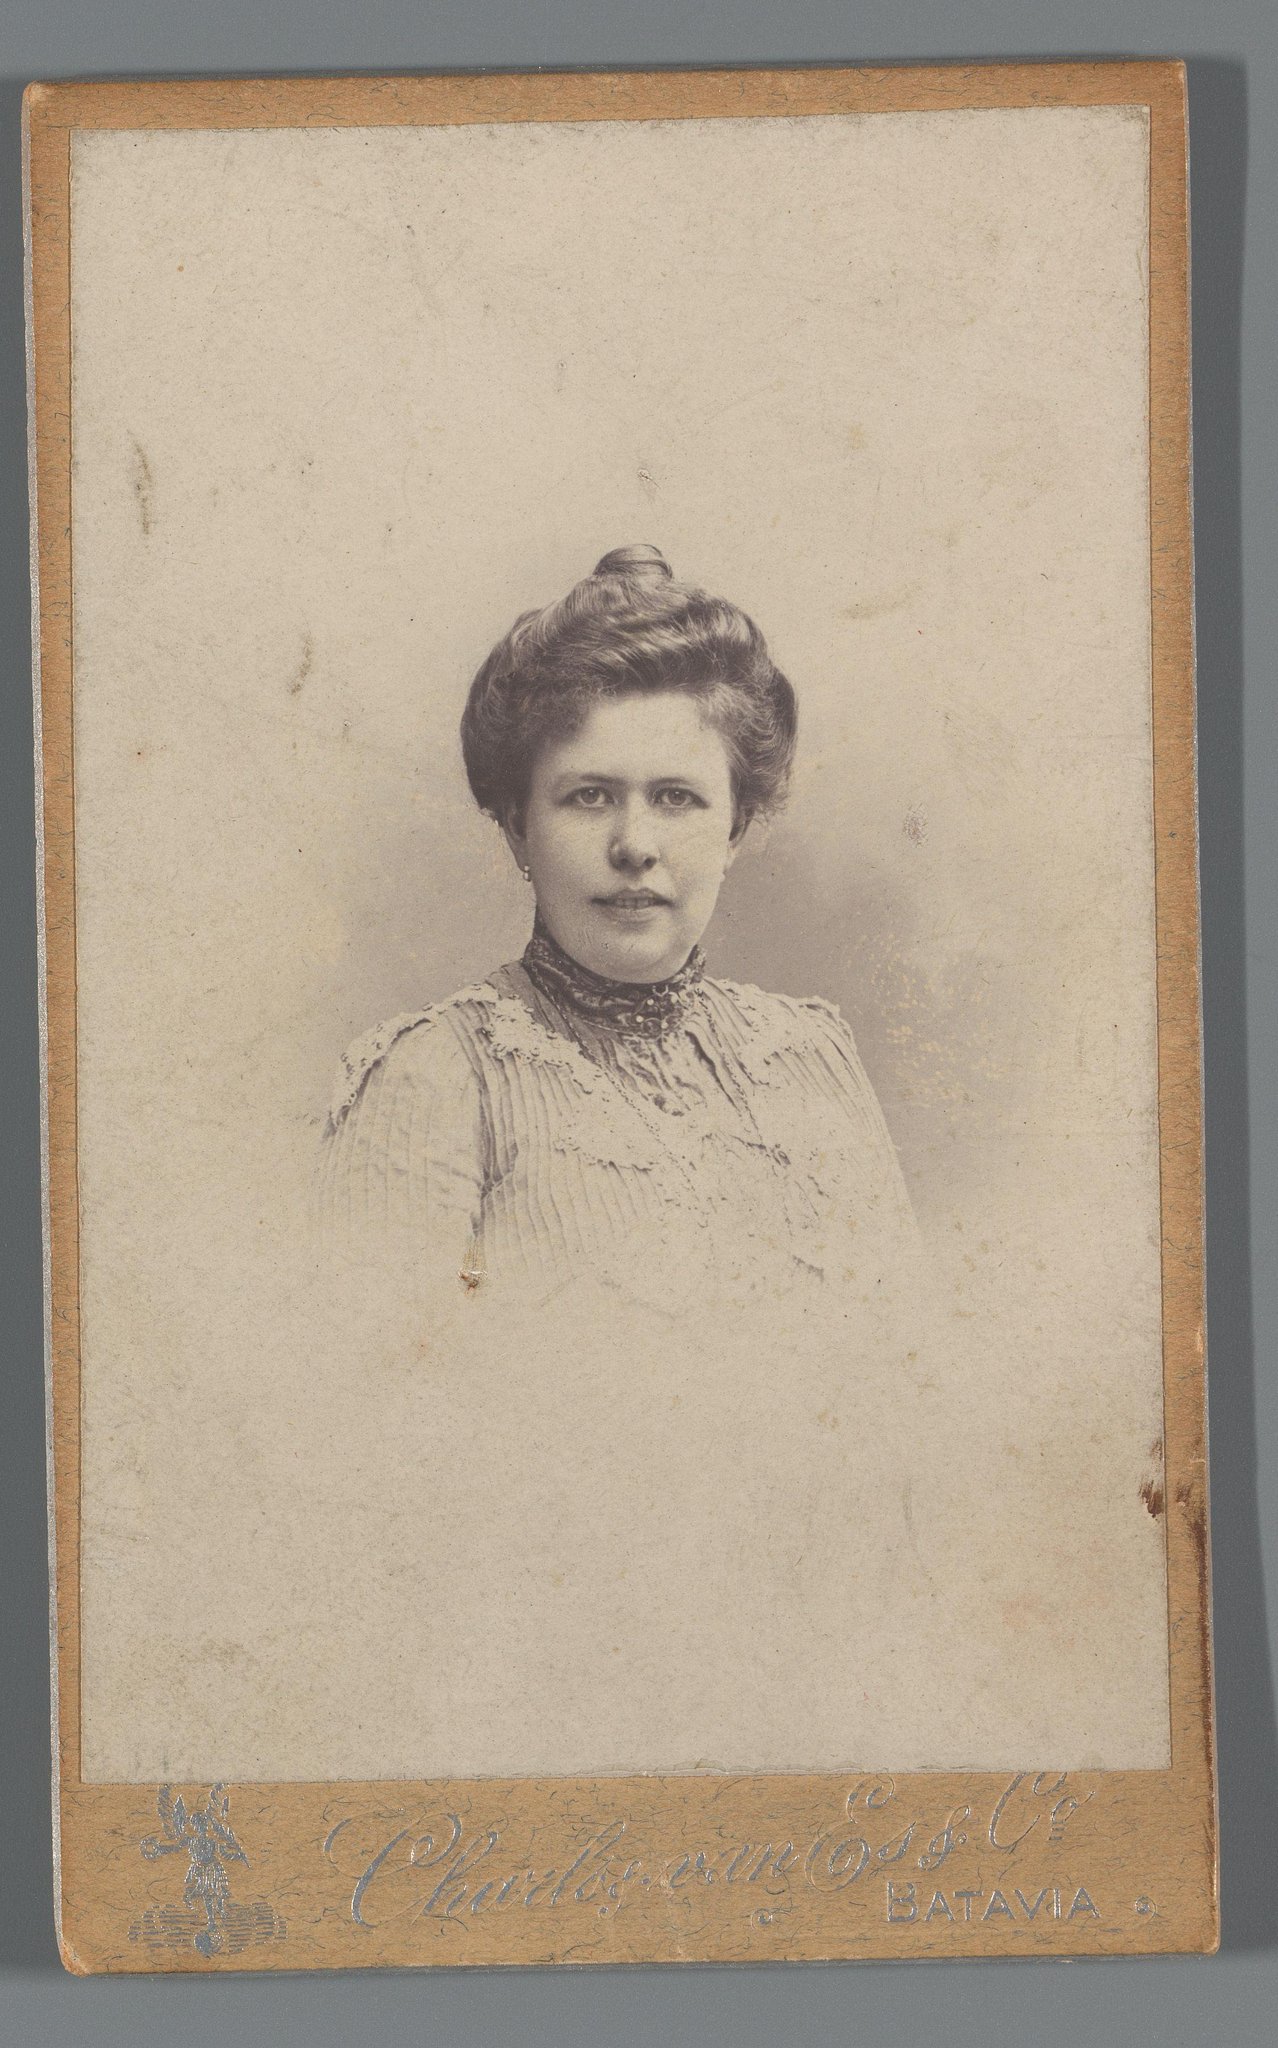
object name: photograph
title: Studioportret van Poppy Dunlop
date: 1890-1910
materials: cardboard, photographic support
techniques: albumen print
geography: batavia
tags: batavia, amsterdam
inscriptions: name: ‘CHARLS & VAN ES & Co / BATAVIA’, name: ‘Poppy tante Poppy’, name